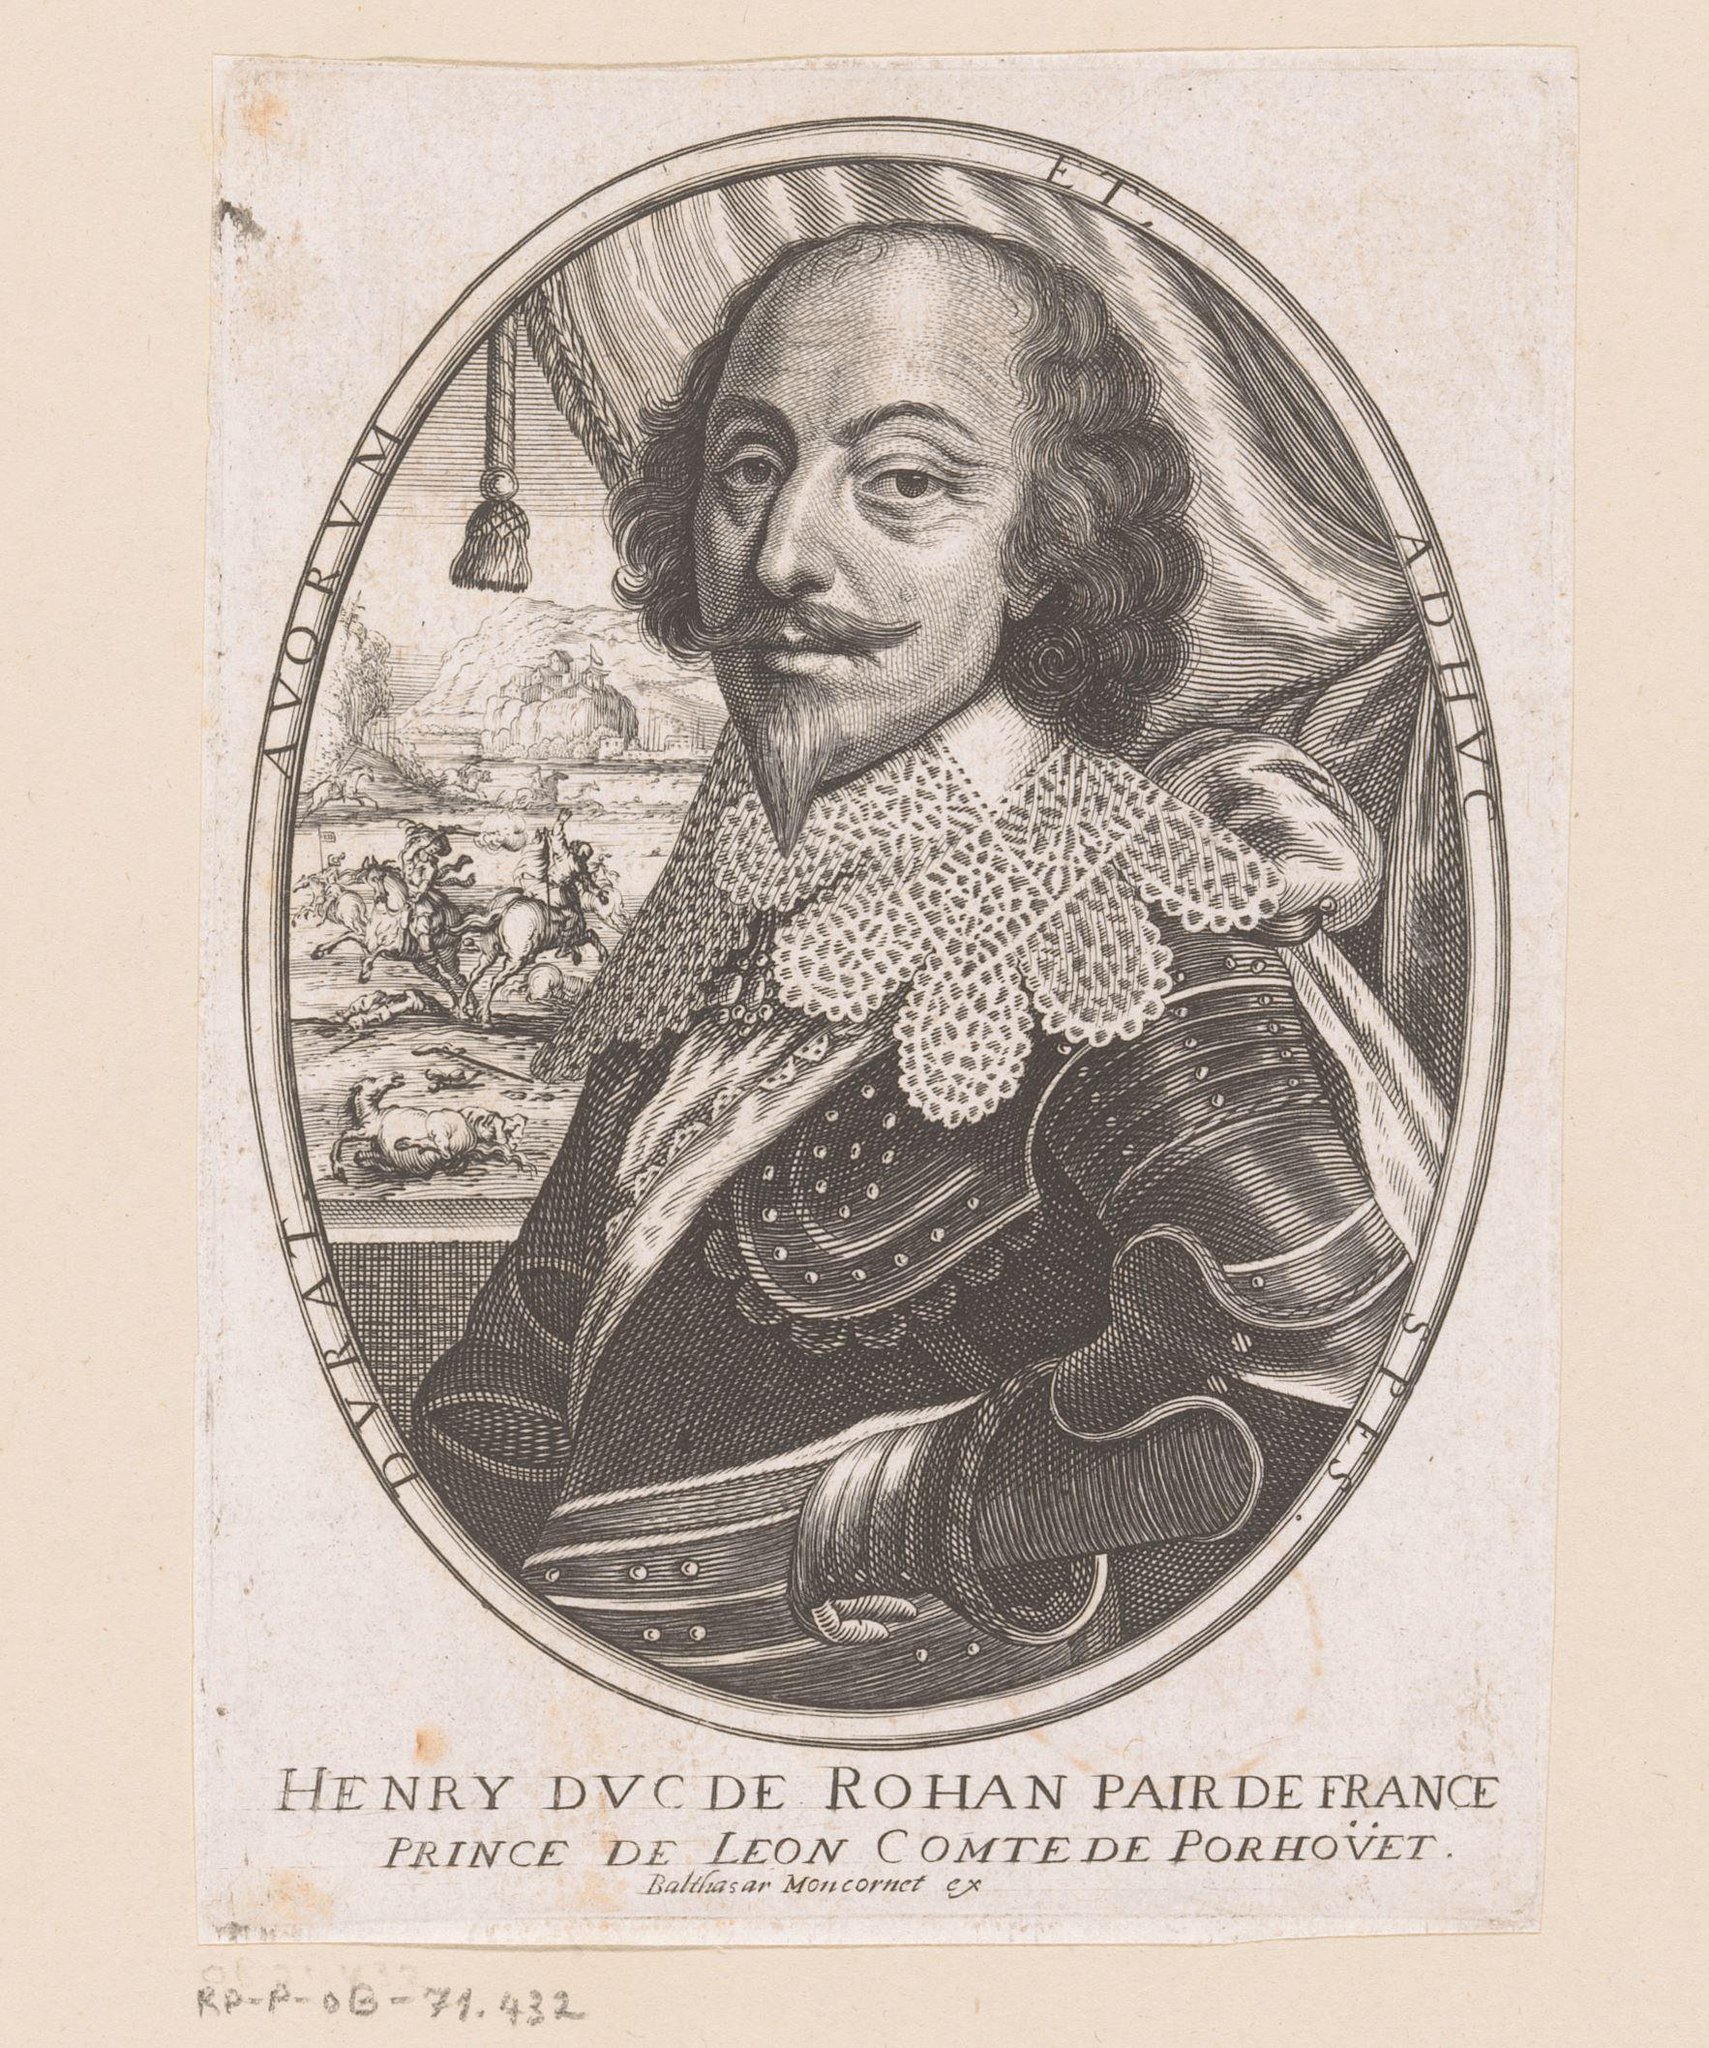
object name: print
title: Portret van Hendrik II van Rohan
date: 1610-1668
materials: paper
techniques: engraving, etching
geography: paris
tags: ranks in the army, historical persons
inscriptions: collector's mark: Lugt 240